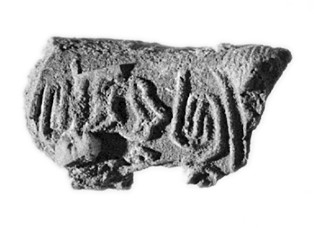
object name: sealing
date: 1981-1640 BCE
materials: mud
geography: egypt